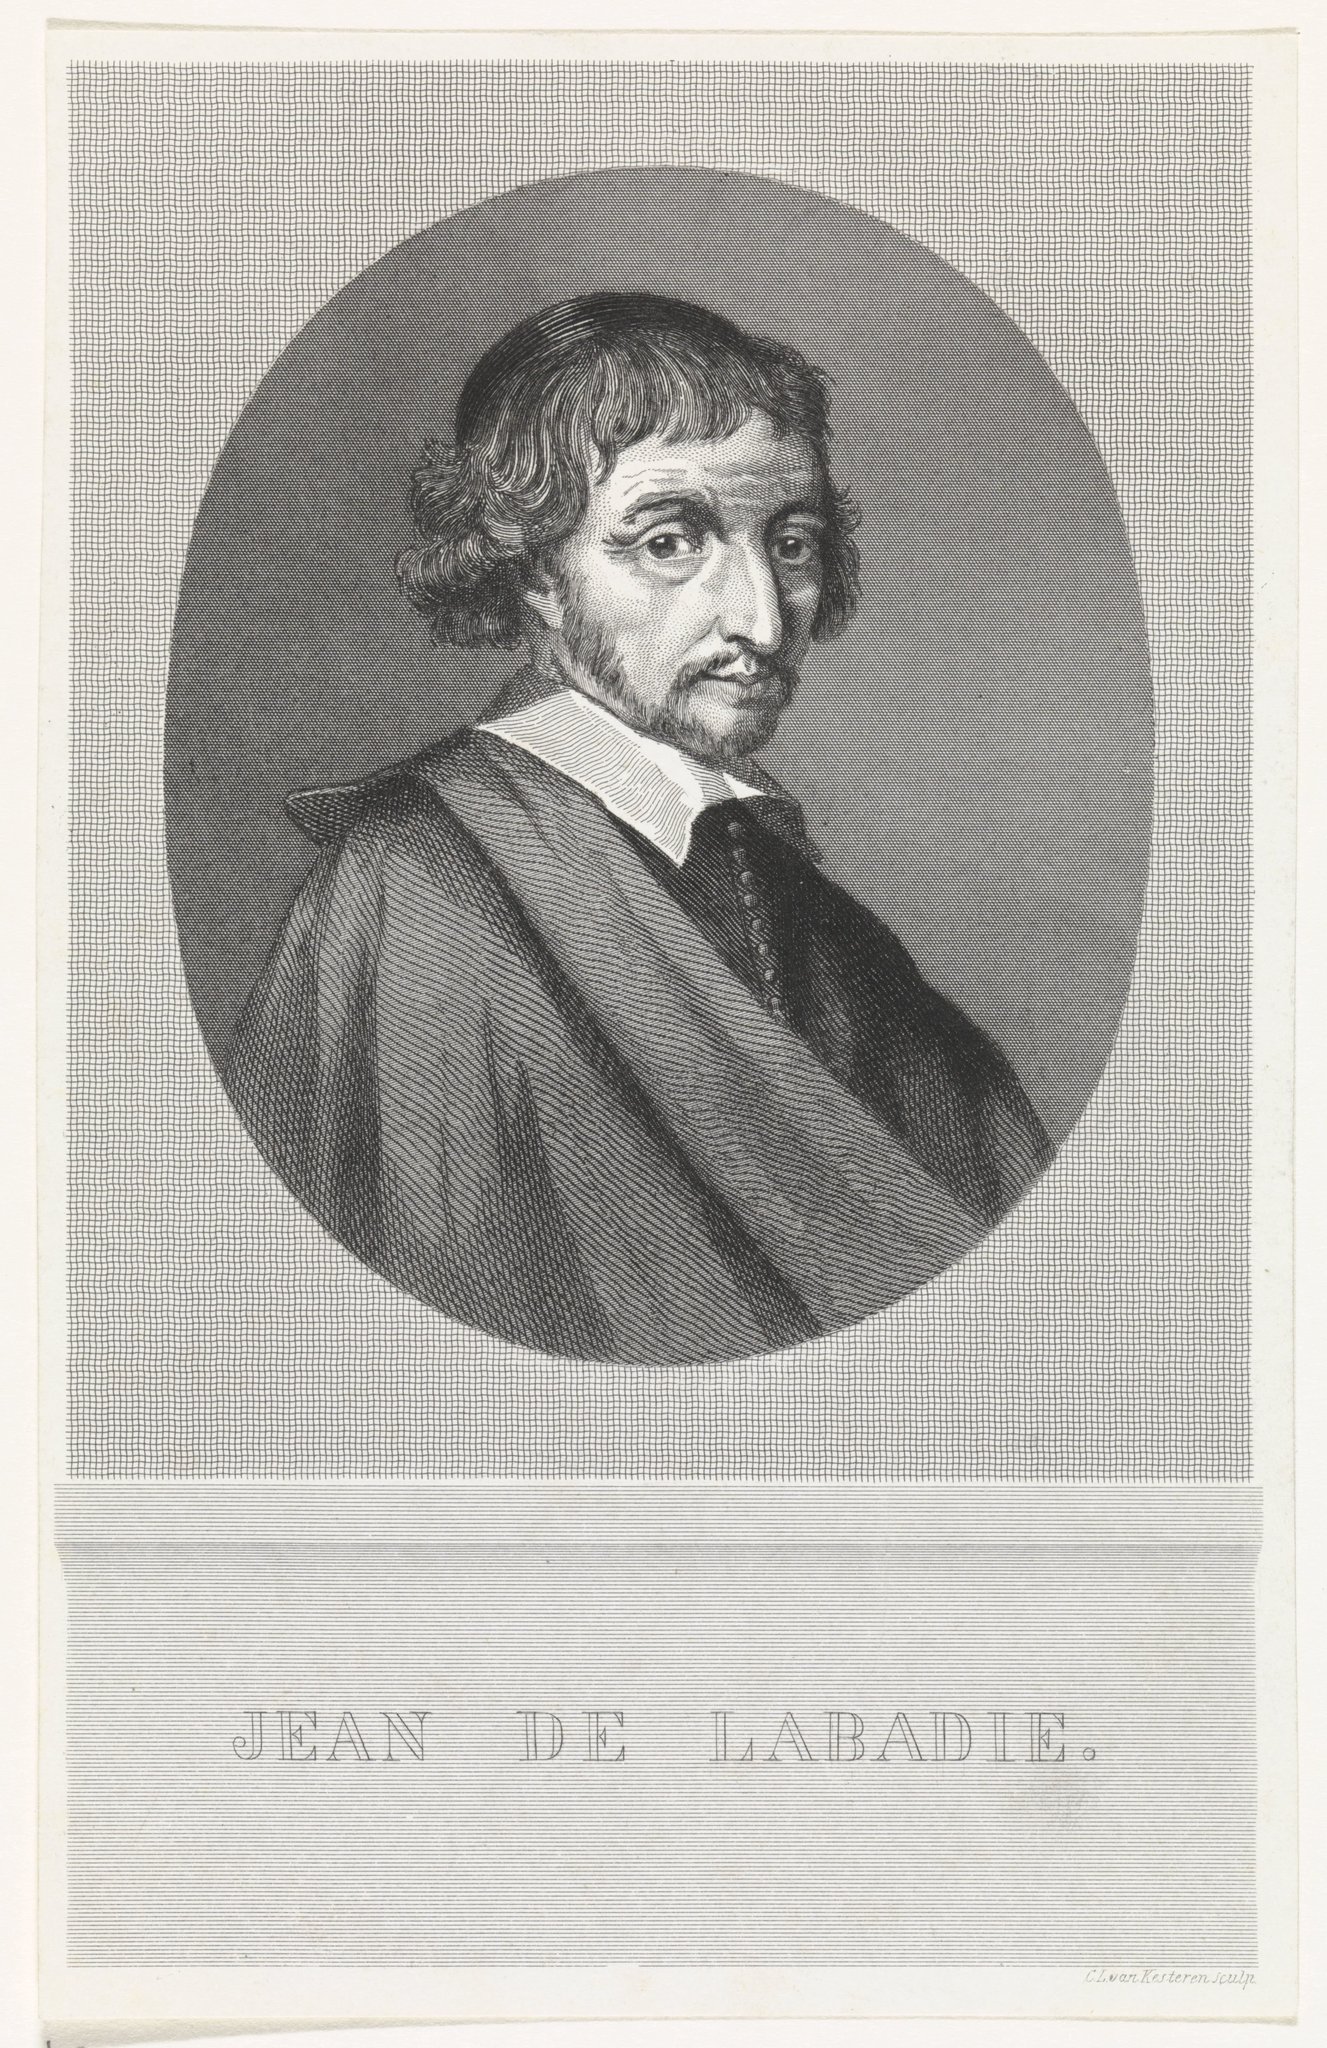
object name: print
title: Portret van Jean de Labadie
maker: christiaan lodewijk van kesteren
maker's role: print maker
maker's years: 1832-1897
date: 1842-1897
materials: paper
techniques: engraving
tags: theologian, historical persons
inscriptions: collector's mark: Lugt 2228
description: Portret in een ovaal naar rechts van de Fransman Jean de Labadie. Hij was predikant van de Waalse gemeente te Middelburg en de oprichter en naamgever van de sekte der labadisten.